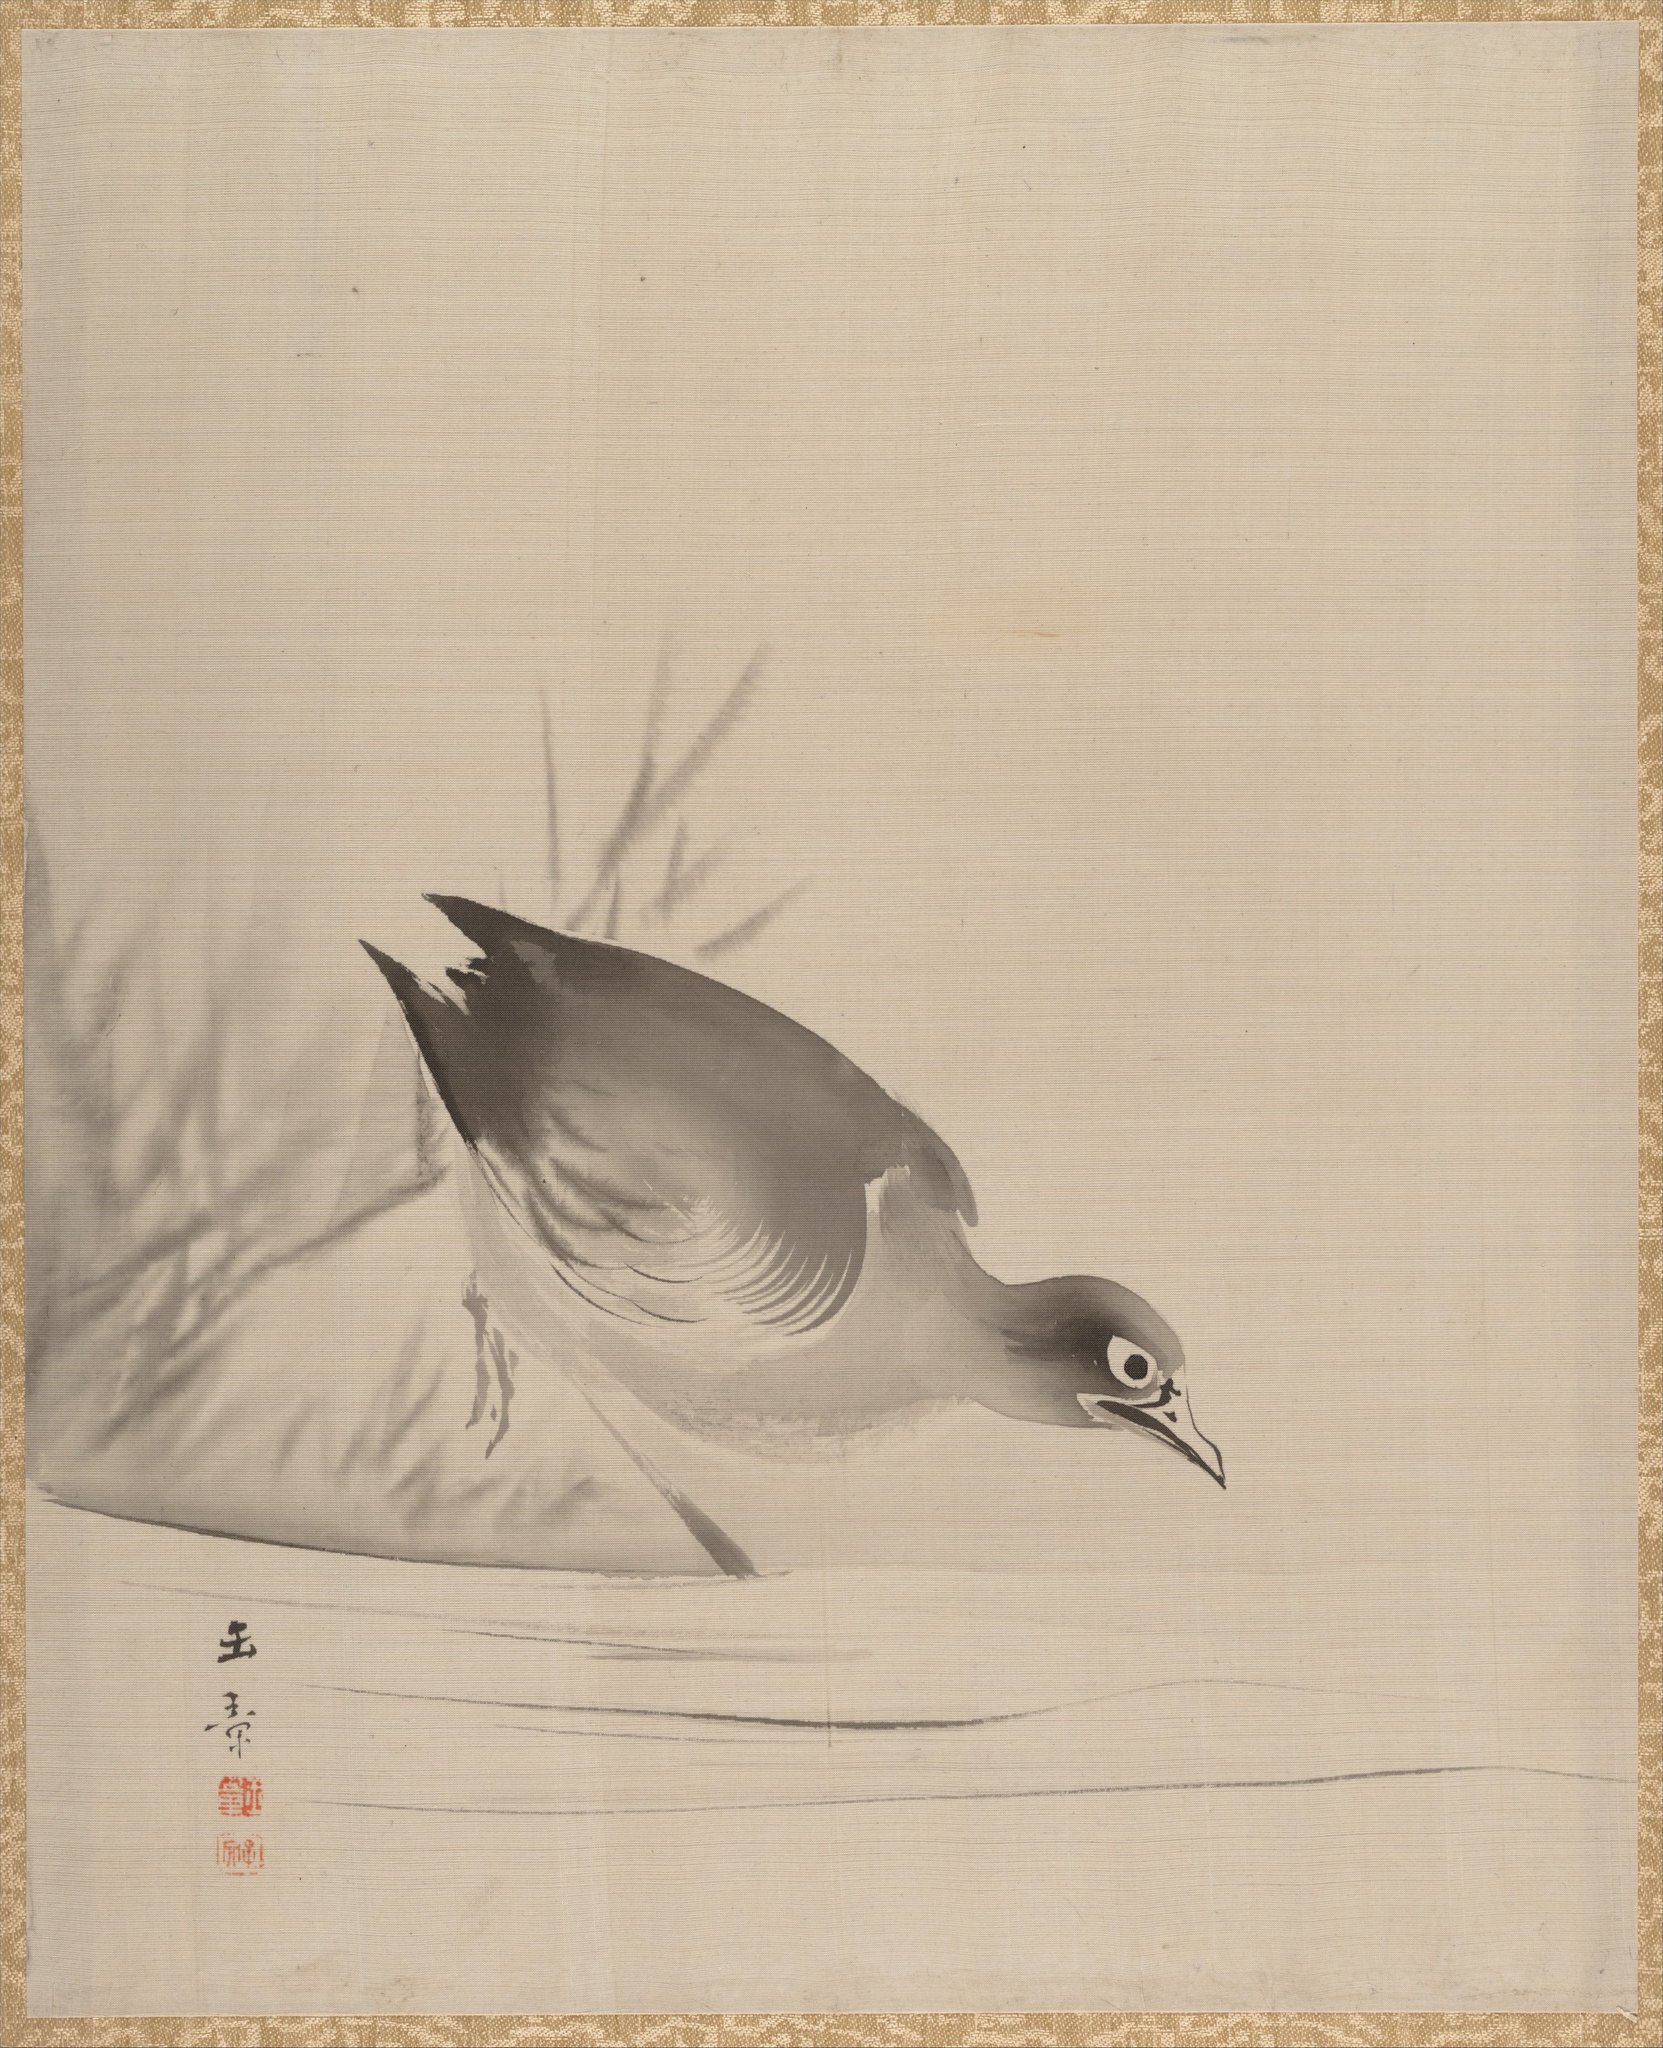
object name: album leaf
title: Bird at the Water's Edge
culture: japanese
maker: kawabata gyokushō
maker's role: artist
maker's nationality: japanese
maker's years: 1842-1913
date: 1887-1892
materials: silk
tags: birds